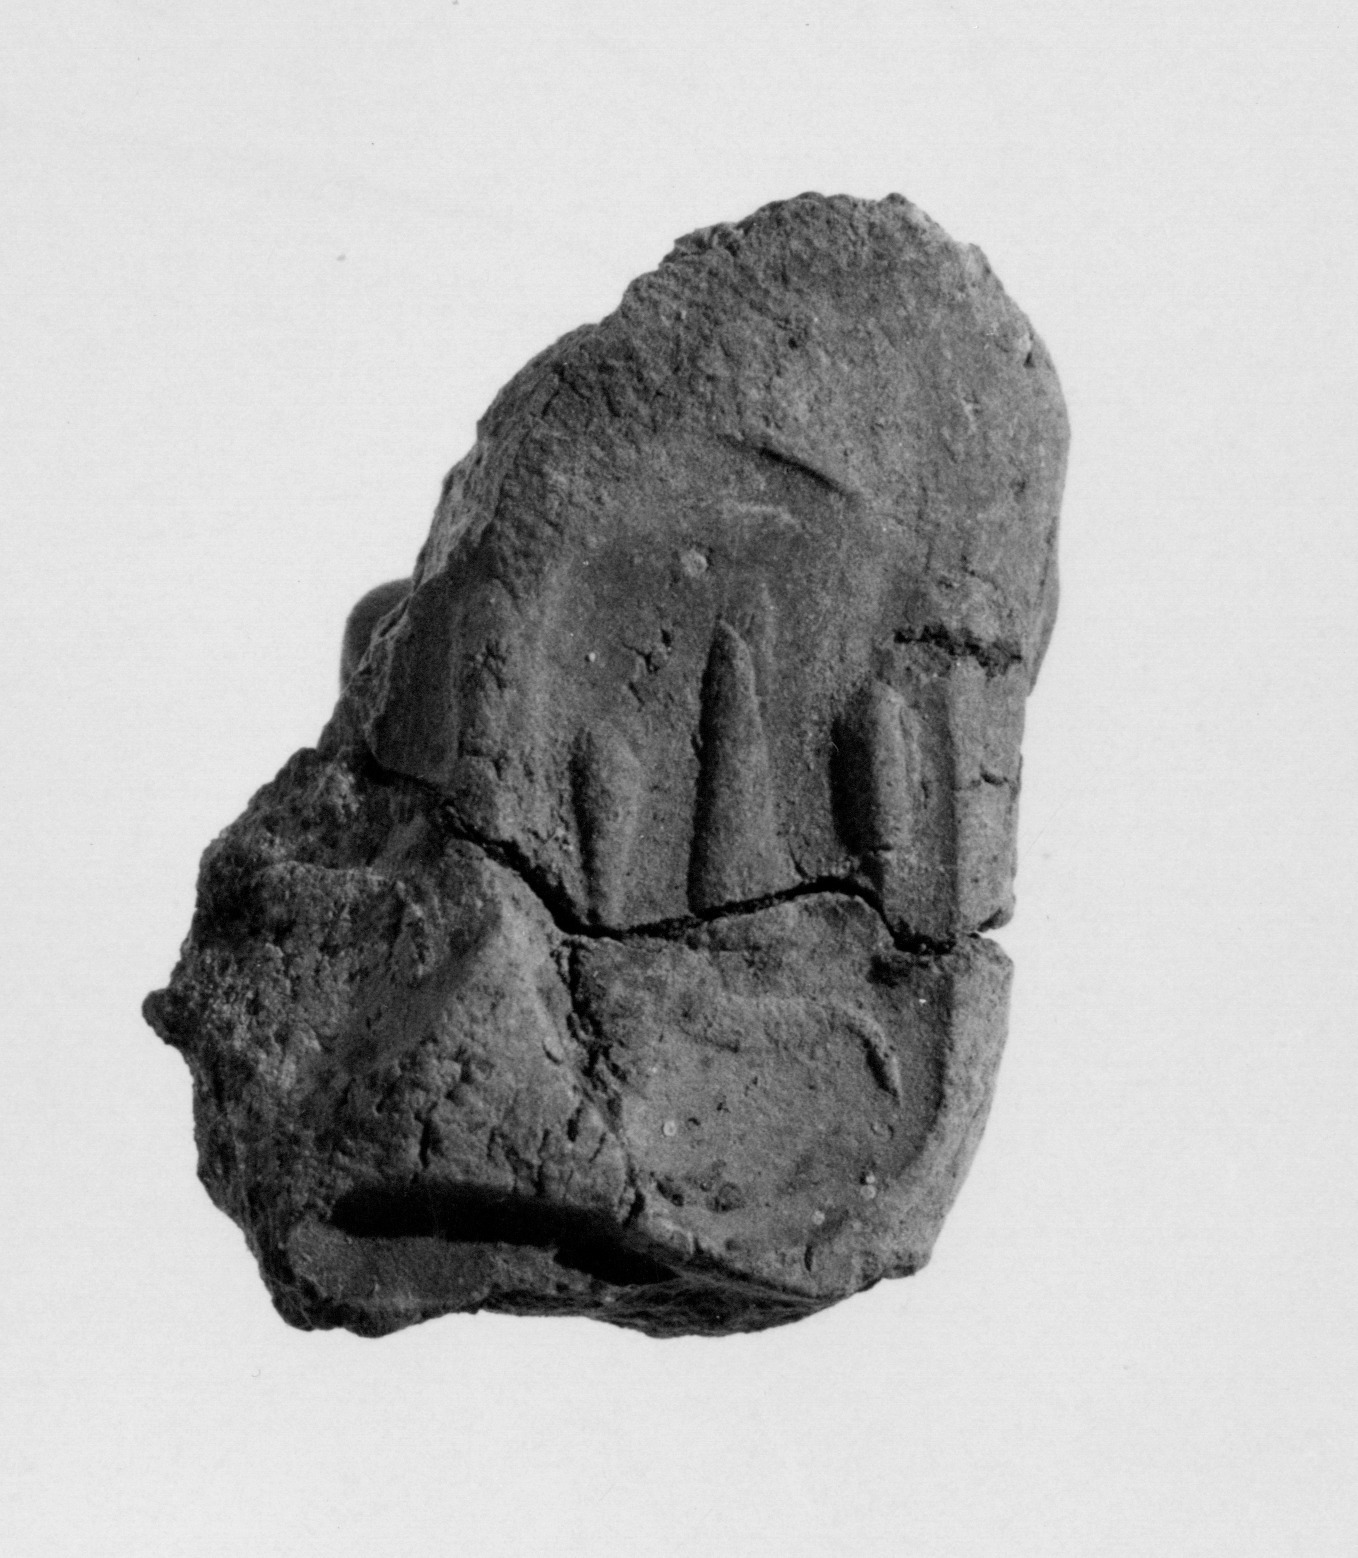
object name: sealing, djed, cobra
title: Document Sealing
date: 1390-1352 BCE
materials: mud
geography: egypt